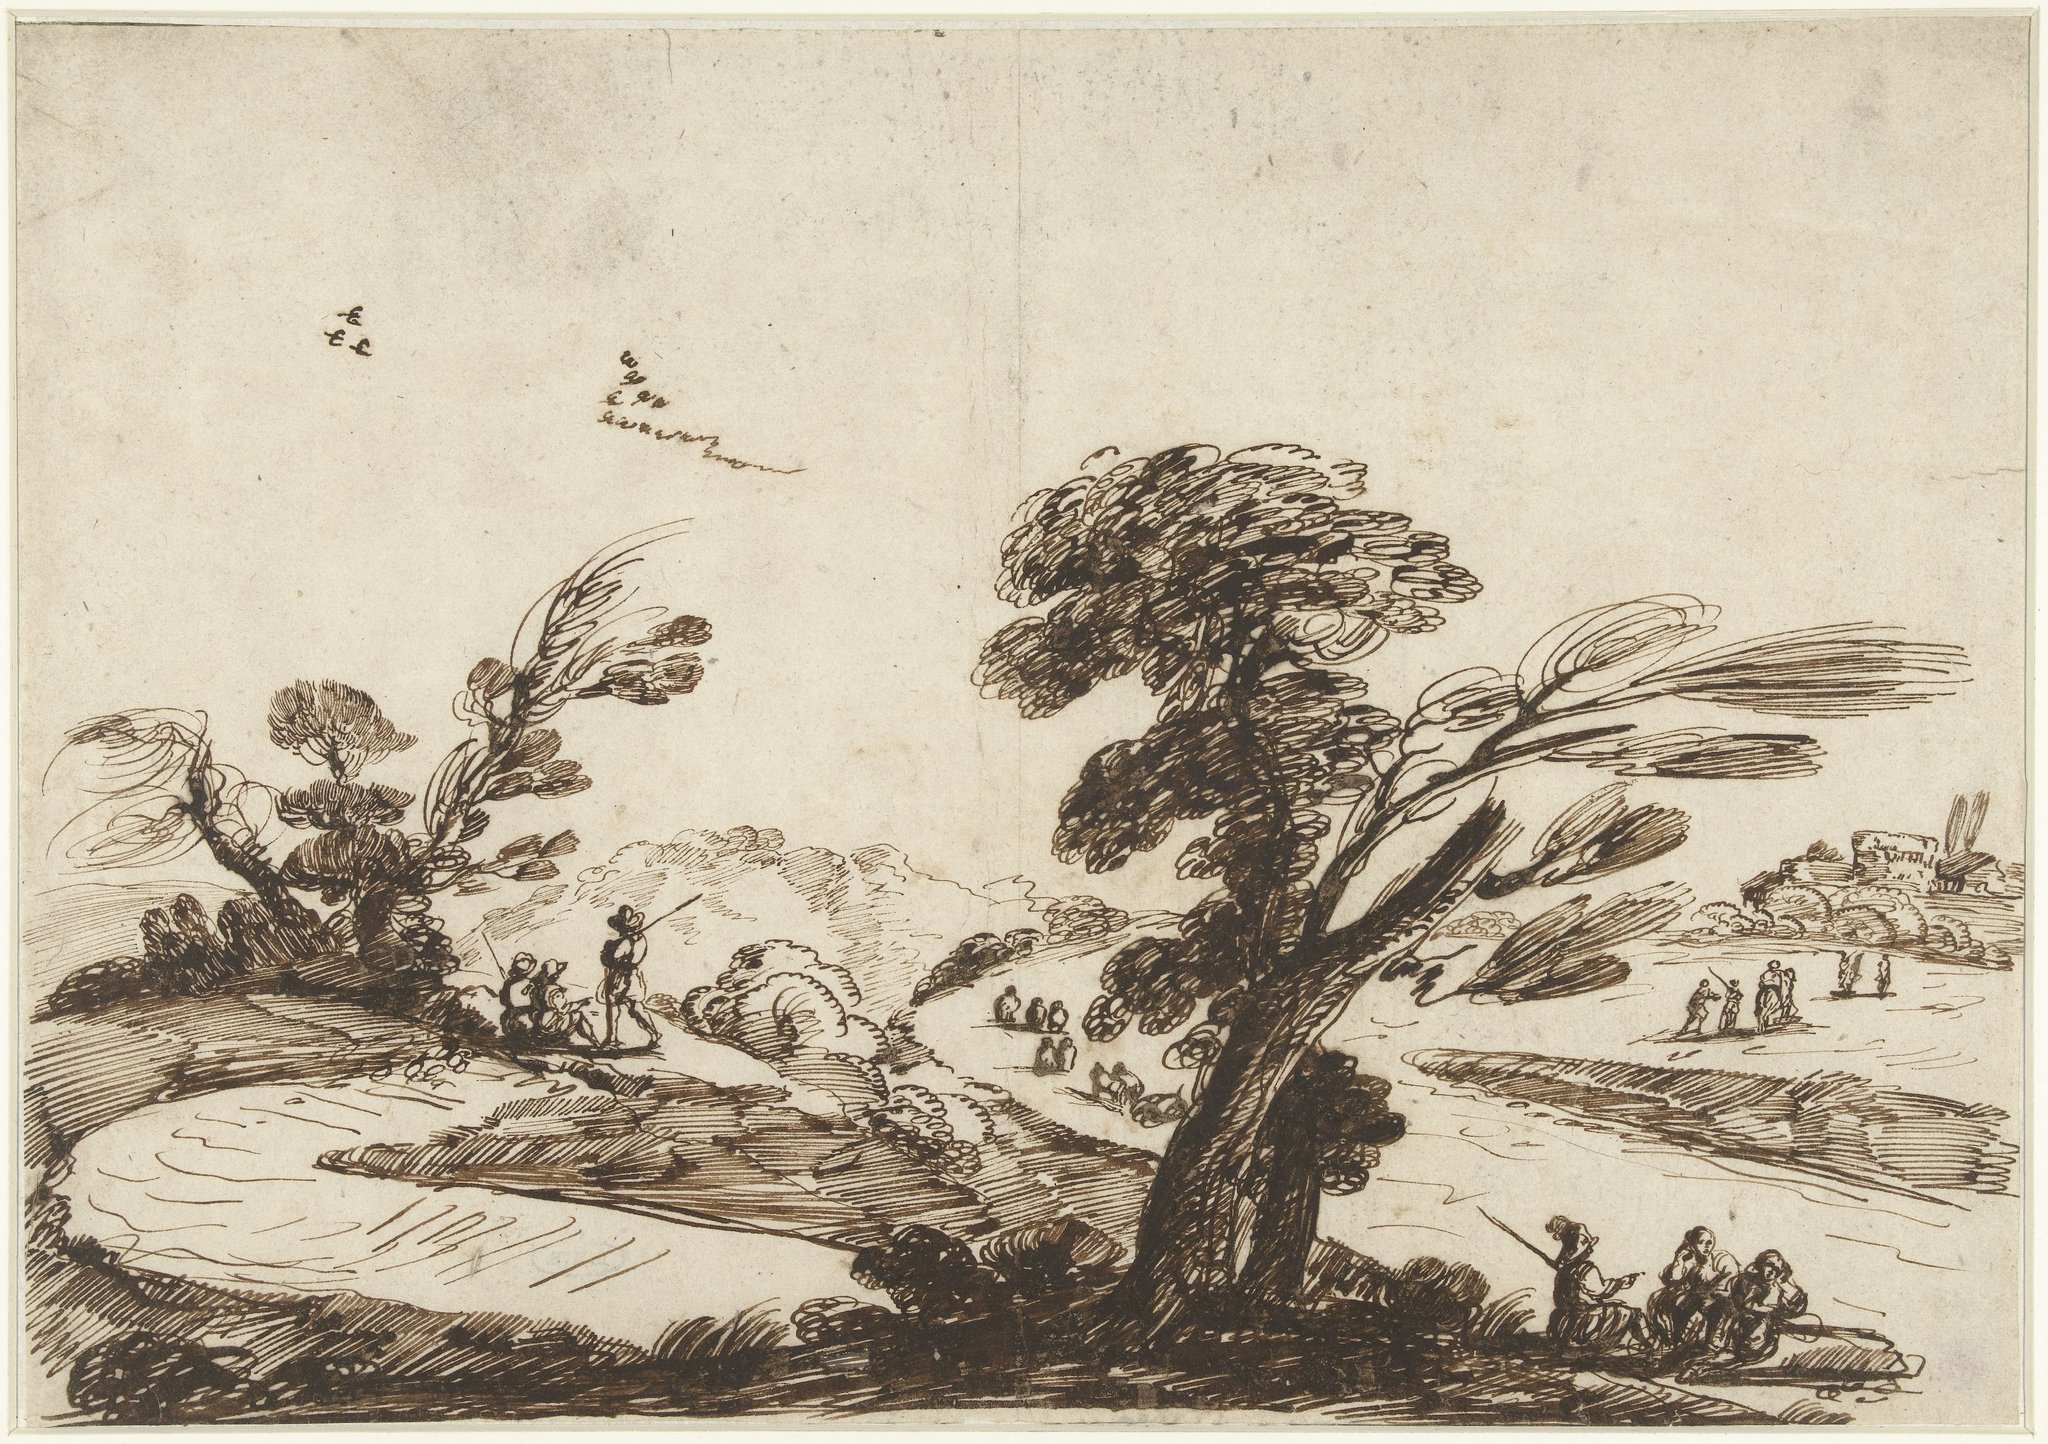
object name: drawing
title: Landschap met figuren en op de voorgrond een grote wilg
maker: g.jo.franc da cento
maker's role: draughtsman, painter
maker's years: 1591-1666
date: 1601-1666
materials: ink, paper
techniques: pen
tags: landscapes in the temperate zone